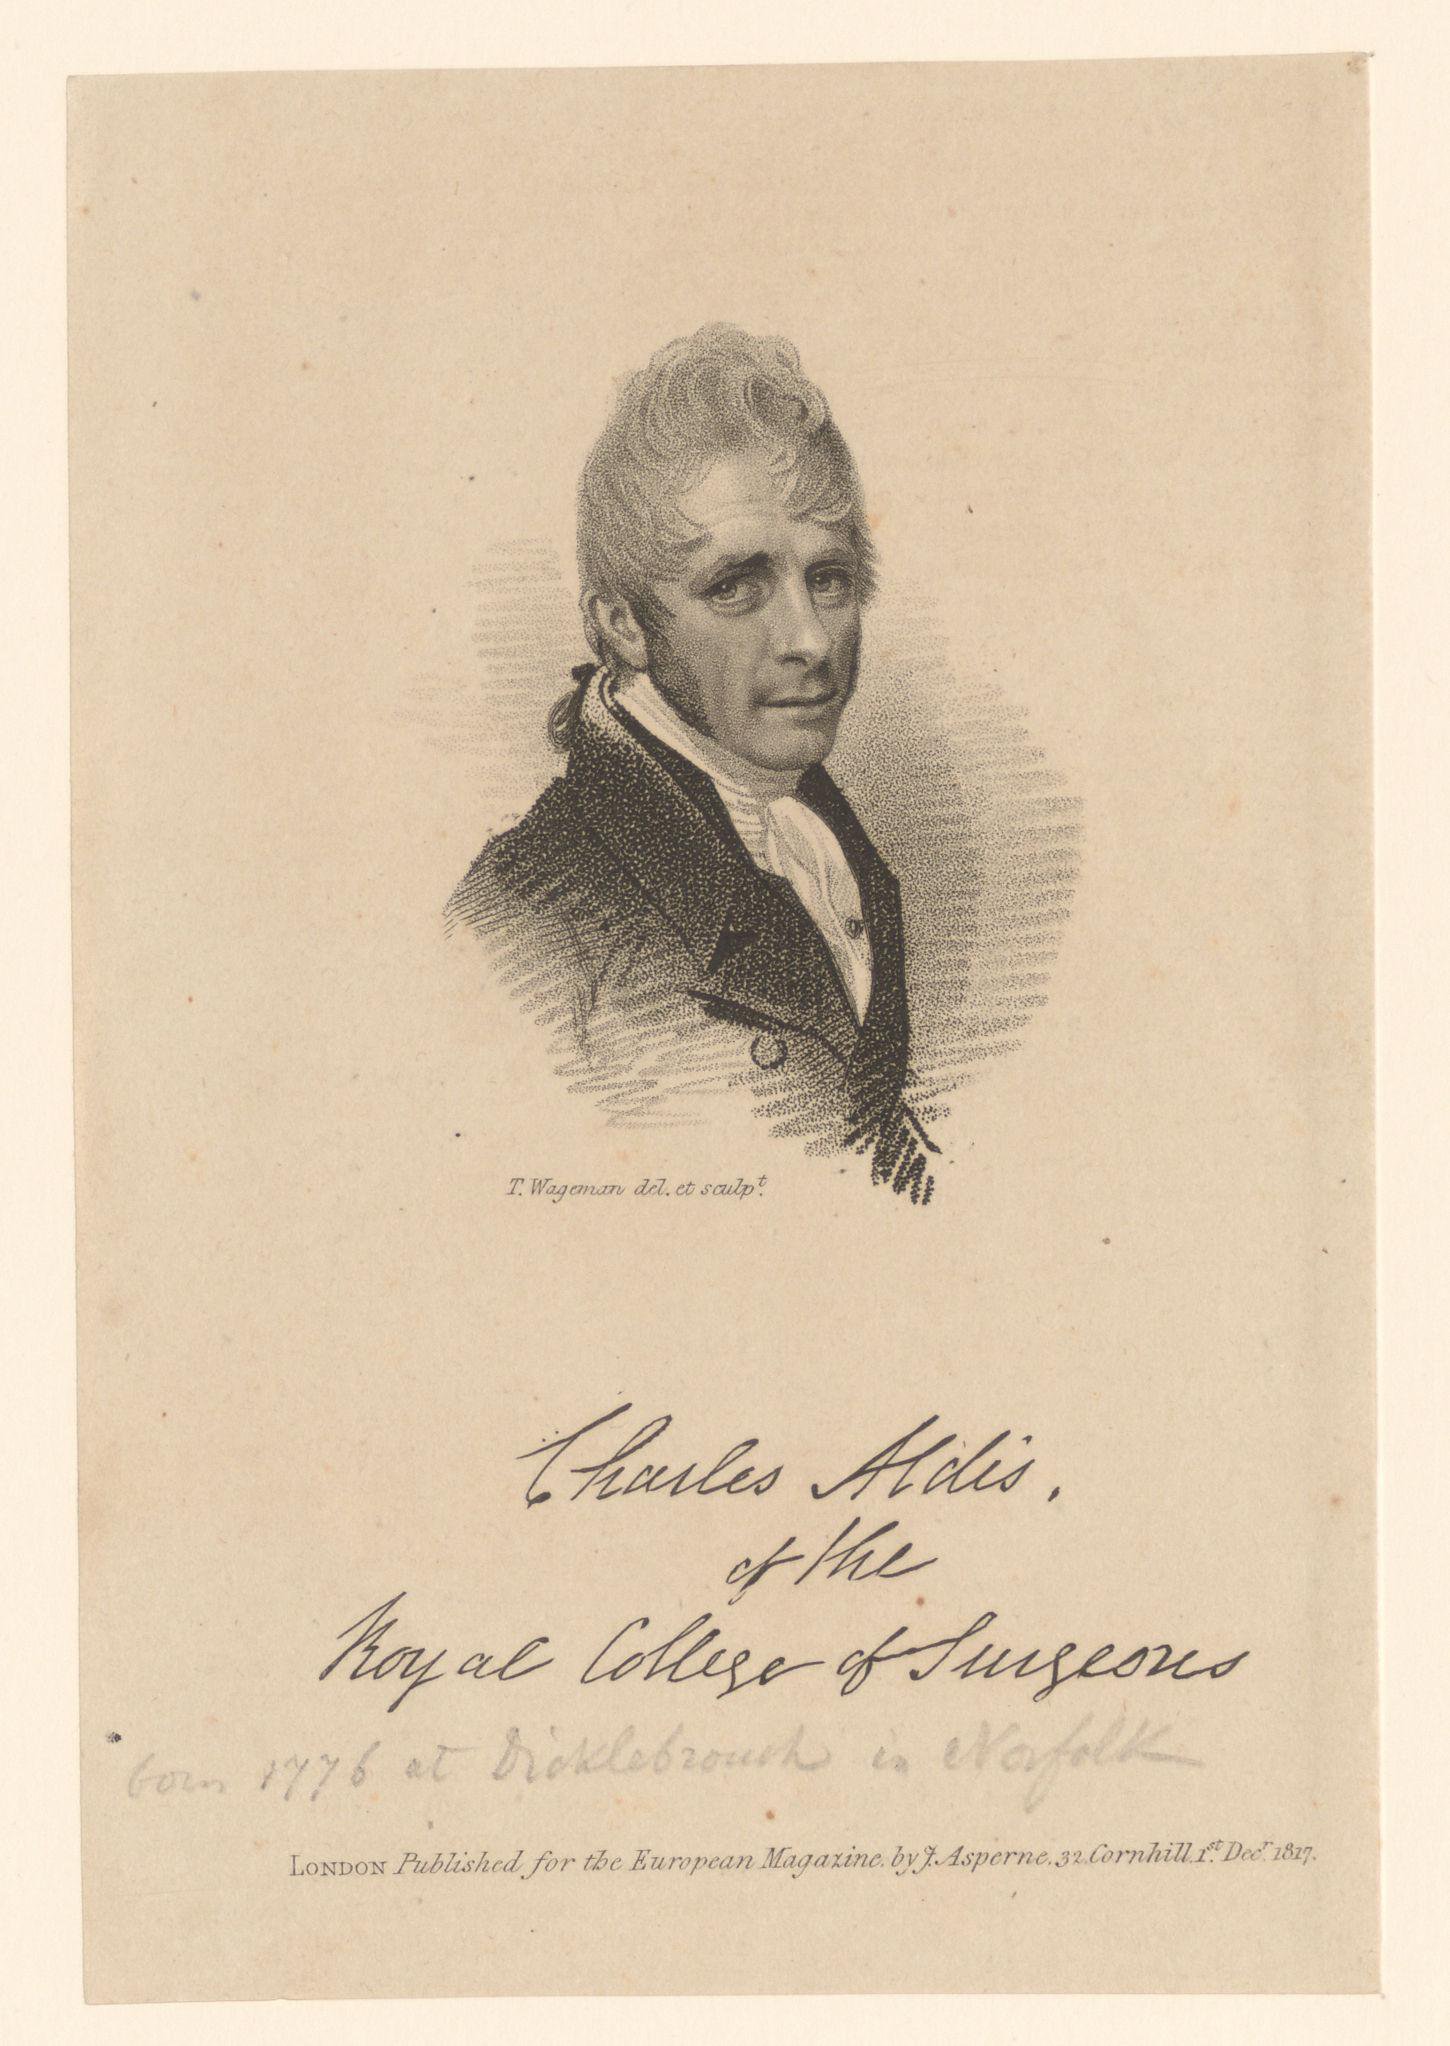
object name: print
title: Portret van Charles Aldis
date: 1817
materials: paper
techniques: printmaking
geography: london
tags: barber; surgeon (+ portrait of scholar, scientist), historical persons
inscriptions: collector's mark: Lugt 2228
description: Prent gebruikt in: European Magazine, 1827.